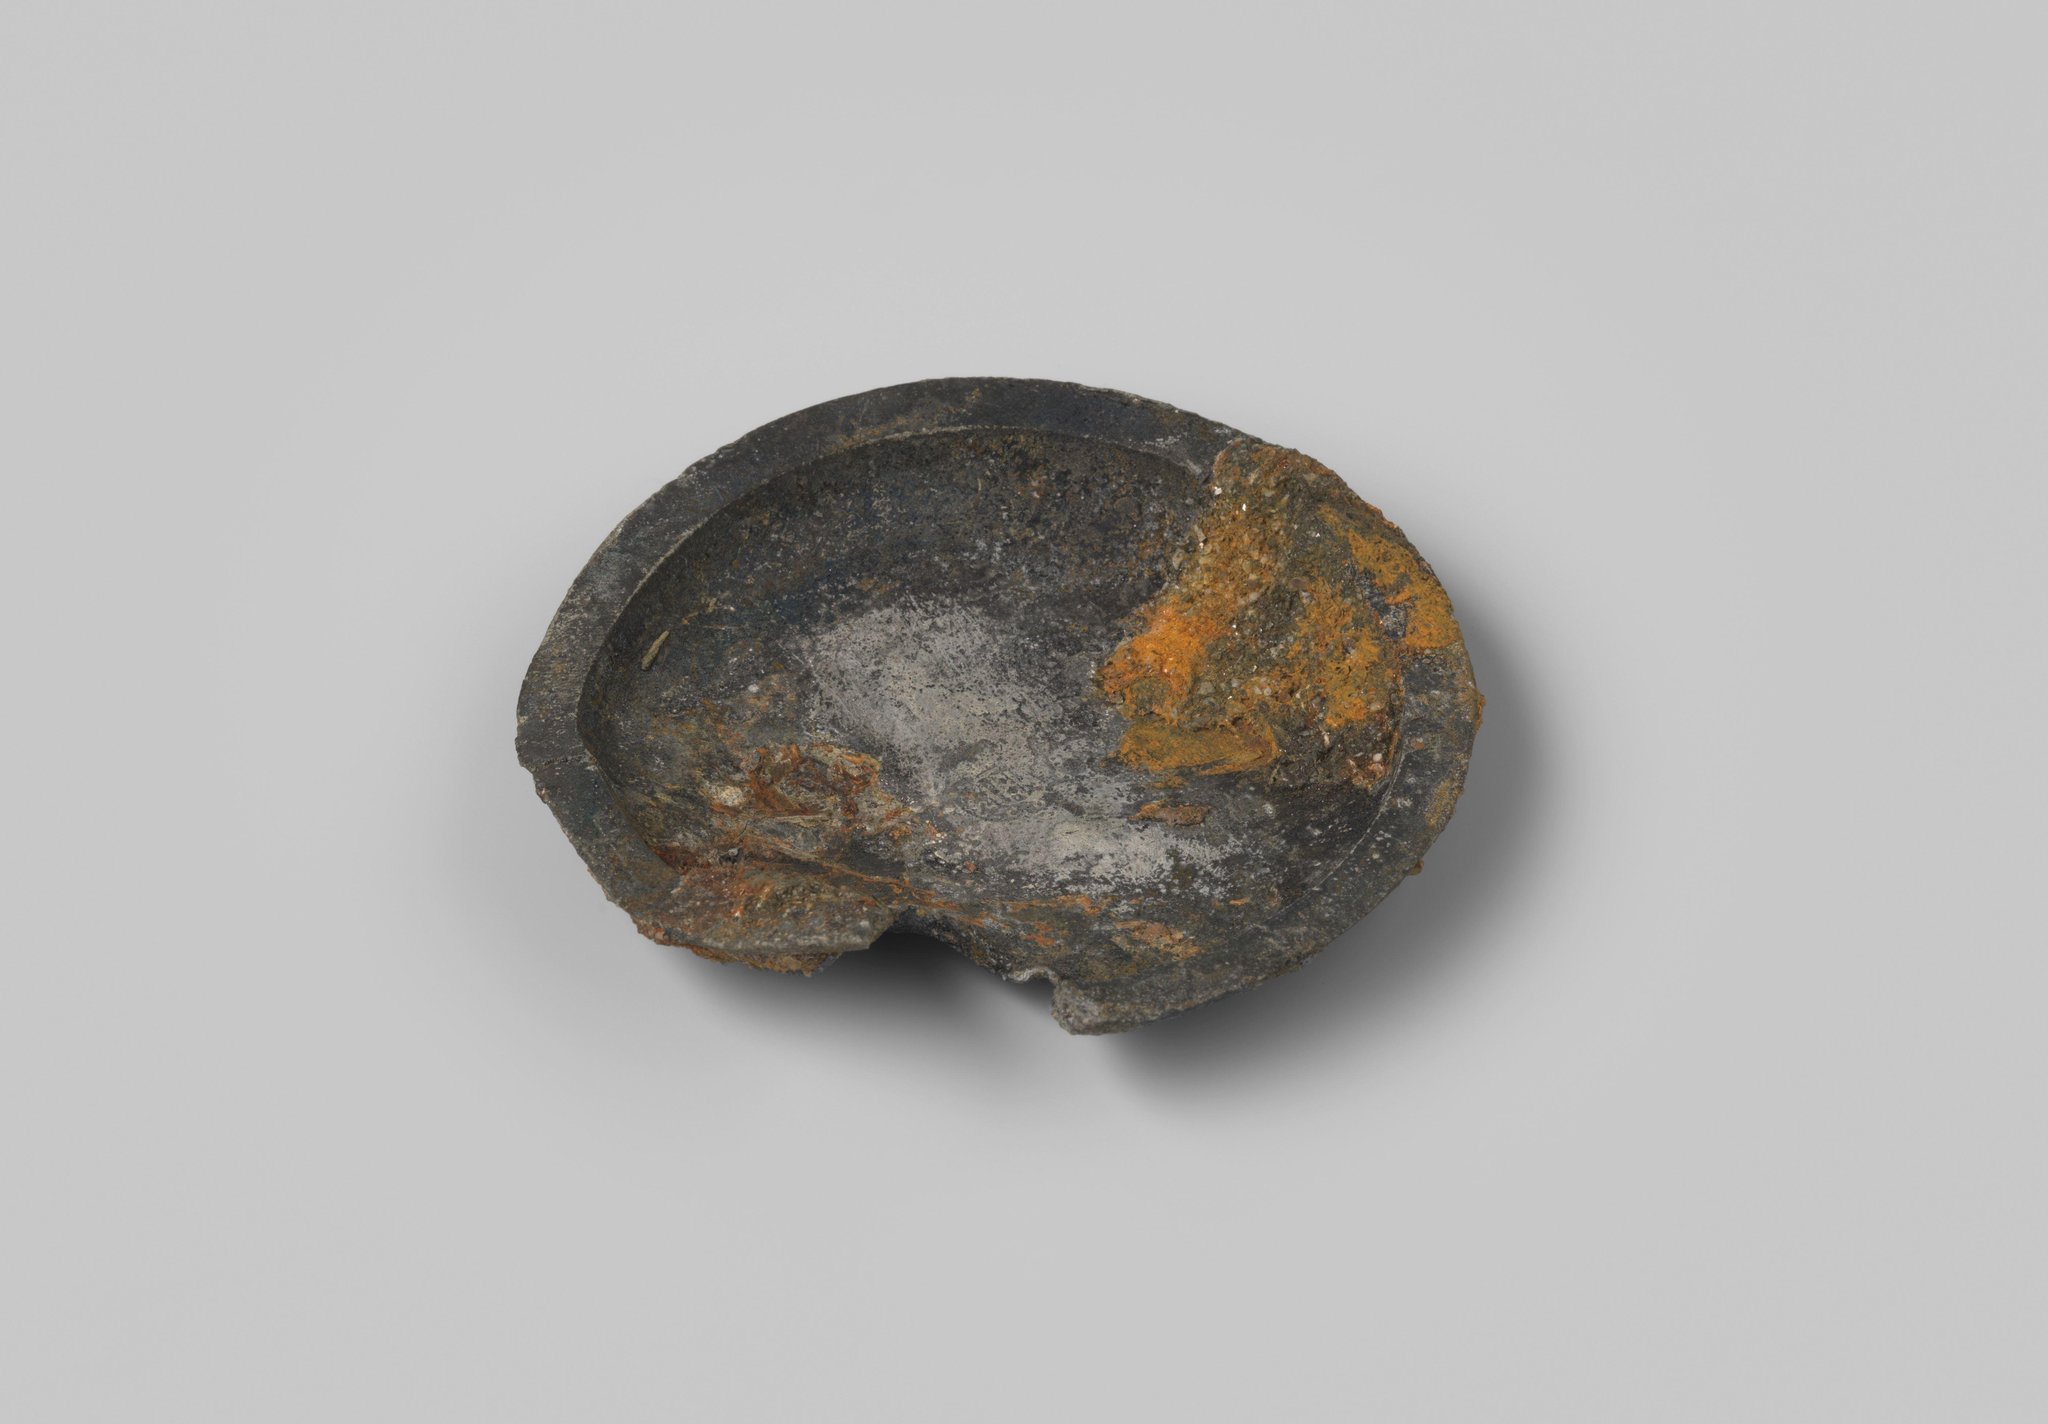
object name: lid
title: Deksel van een kan uit het wrak van de Oost-Indiëvaarder Hollandia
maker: Anonymous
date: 1700-1743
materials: tin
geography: netherlands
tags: verenigde oostindische compagnie, hollandia (schip), annet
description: Jug, lid, circular, slightly convex, rim flat underneath, on top engraved concentric circles in centre and along rim, square indentation in rim where thumbpiece was fitted. Coat of arms of Amsterdam.